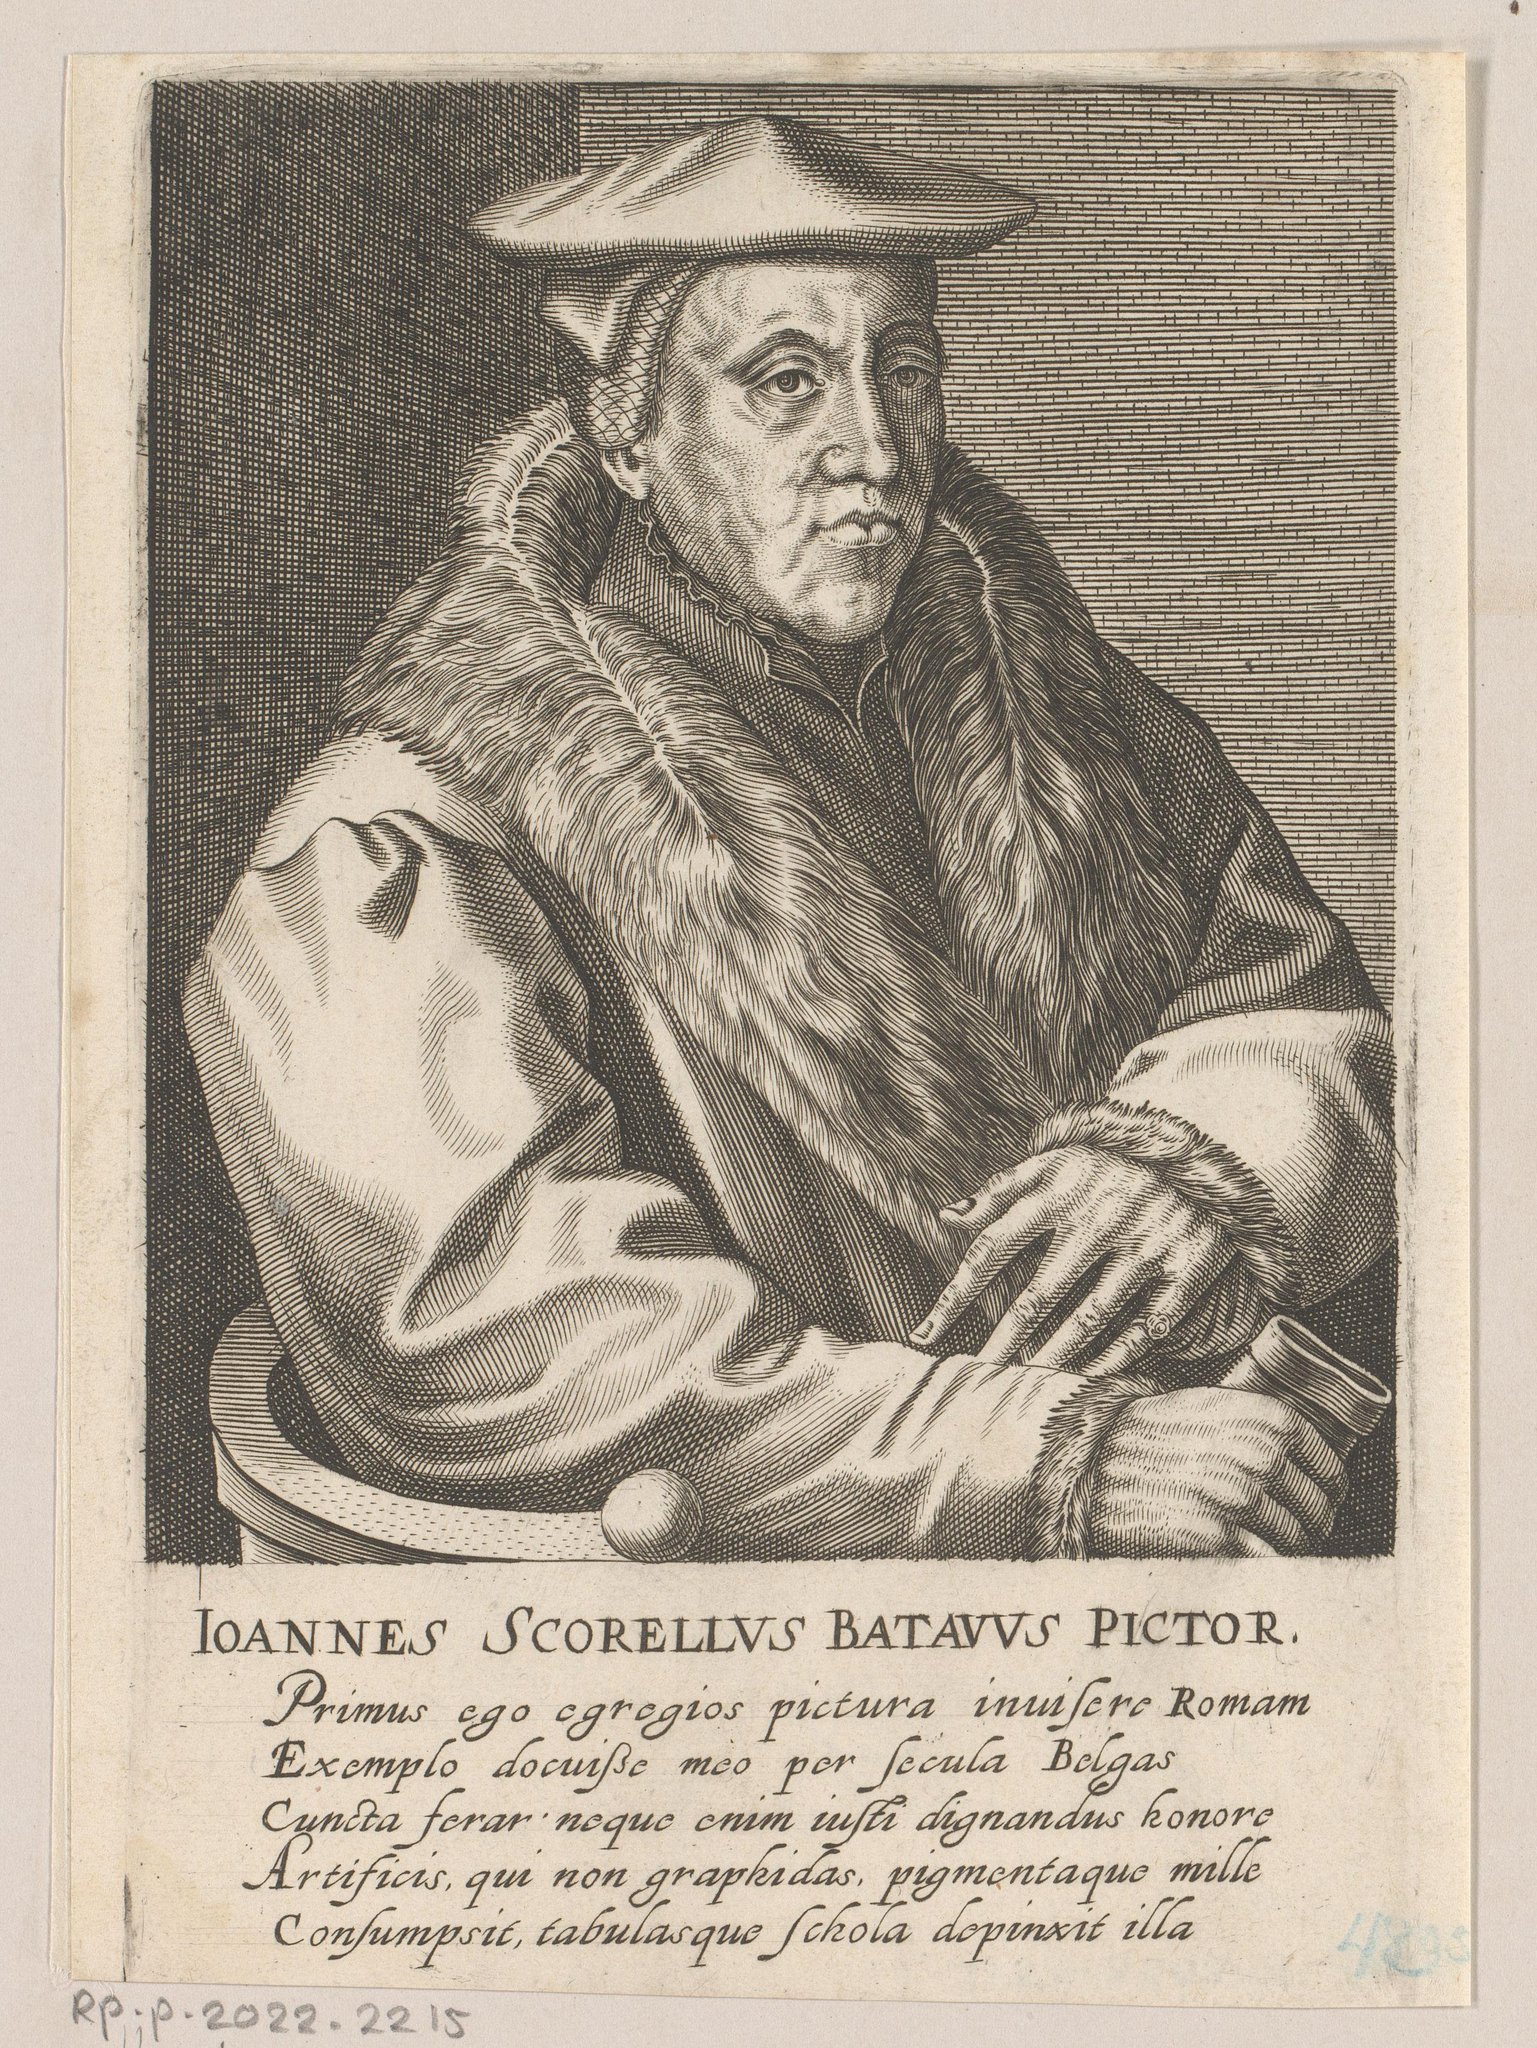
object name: print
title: Portretten van beroemde schilders uit de Lage Landen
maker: hendrick hondius (i)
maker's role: draughtsman, print maker, publisher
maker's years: 1573-1650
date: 1610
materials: paper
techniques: engraving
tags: utrecht, painter, jan van scorel, historical persons, portrait, self-portrait of artist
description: Prent waarschijnlijk uit: Hondius, Hendrick. Pictorum aliquot celebrium praecipué Germaniae Inferioris effigies. Den Haag: Hendrick Hondius, 1610.